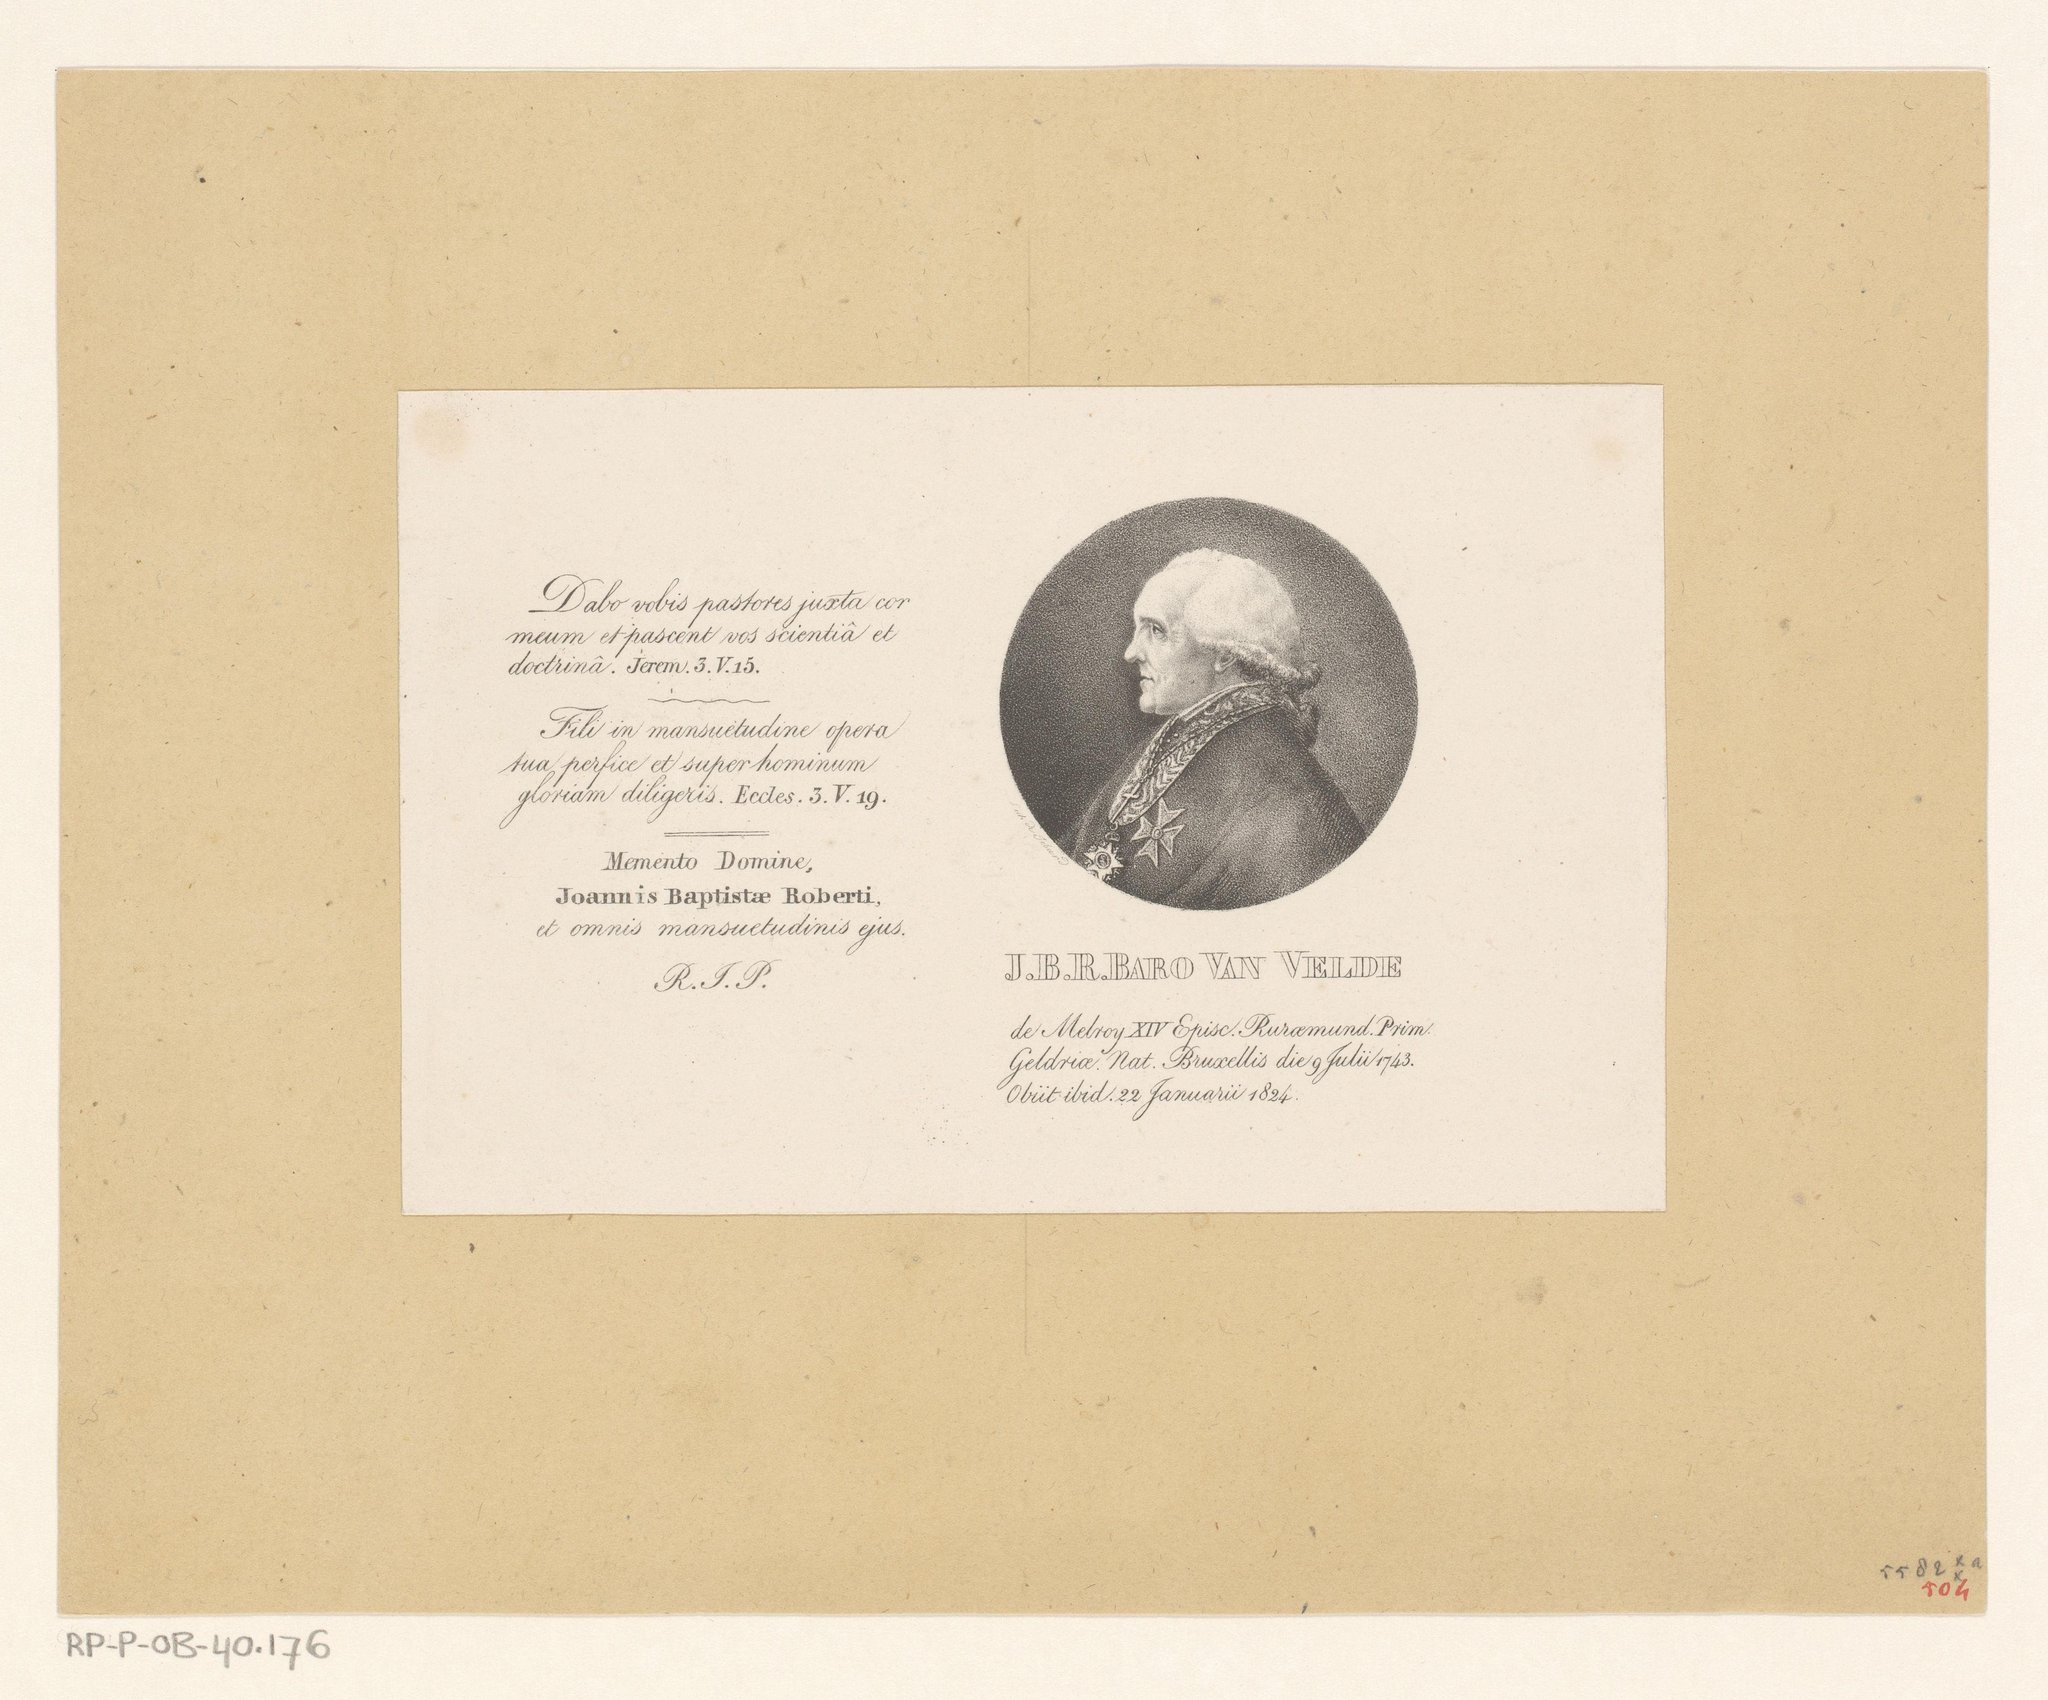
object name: print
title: Portret van Jan Baptist Robert baron van Velde tot Melroy en Sart-Bomal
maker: jobard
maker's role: printer, publisher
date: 1824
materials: paper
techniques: lithograph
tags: archbishop, bishop, etc. (roman catholic), historical persons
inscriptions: date